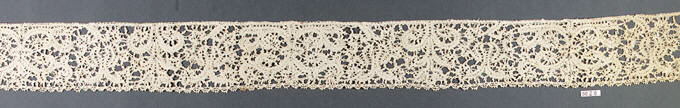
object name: fragment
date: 1650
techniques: lace